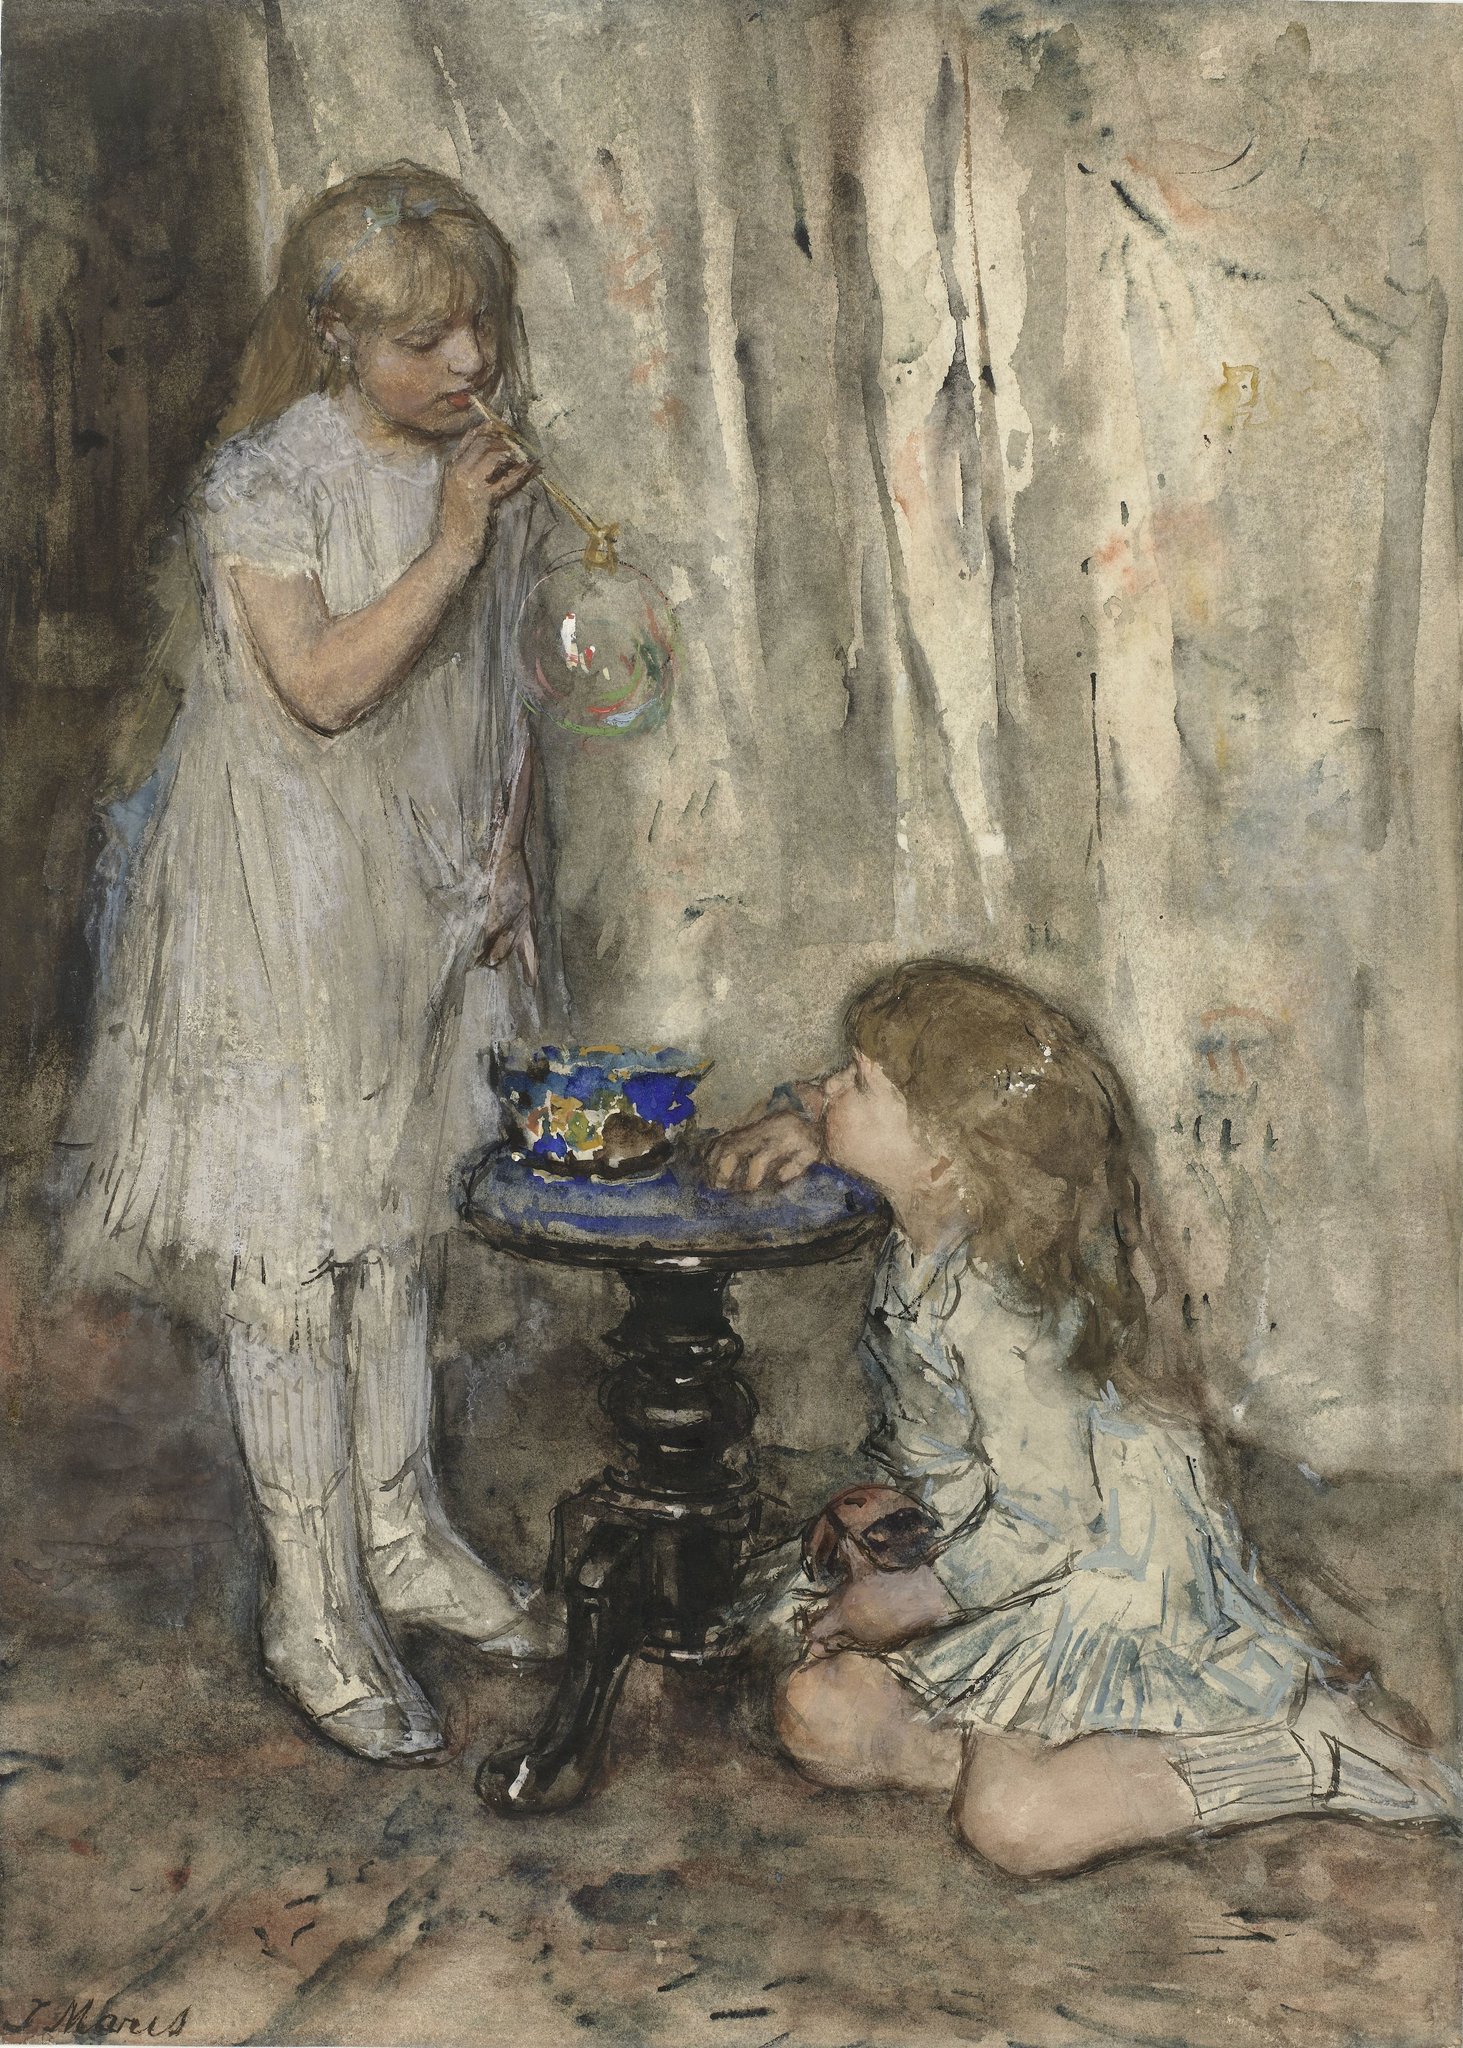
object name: watercolor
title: Two Girls Blowing Bubbles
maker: jacob maris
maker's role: draughtsman, painter, print maker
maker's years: 1837-1899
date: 1880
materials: chalk, paint, paper, watercolor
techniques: brush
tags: bubble-blowing (children's games and plays), girl (child between toddler and youth)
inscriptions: signature: ‘J. Maris’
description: Two of Jacob Maris’s daughters, probably Tine and Henriëtte, are blowing bubbles. Maris often used his children as models for these atmospheric sketches, which were intended for sale. These watercolours were never meant as portraits; the idea was to create the feeling of atmosphere and light. The artist captured the colours of the bowl and the table in the soap bubble.